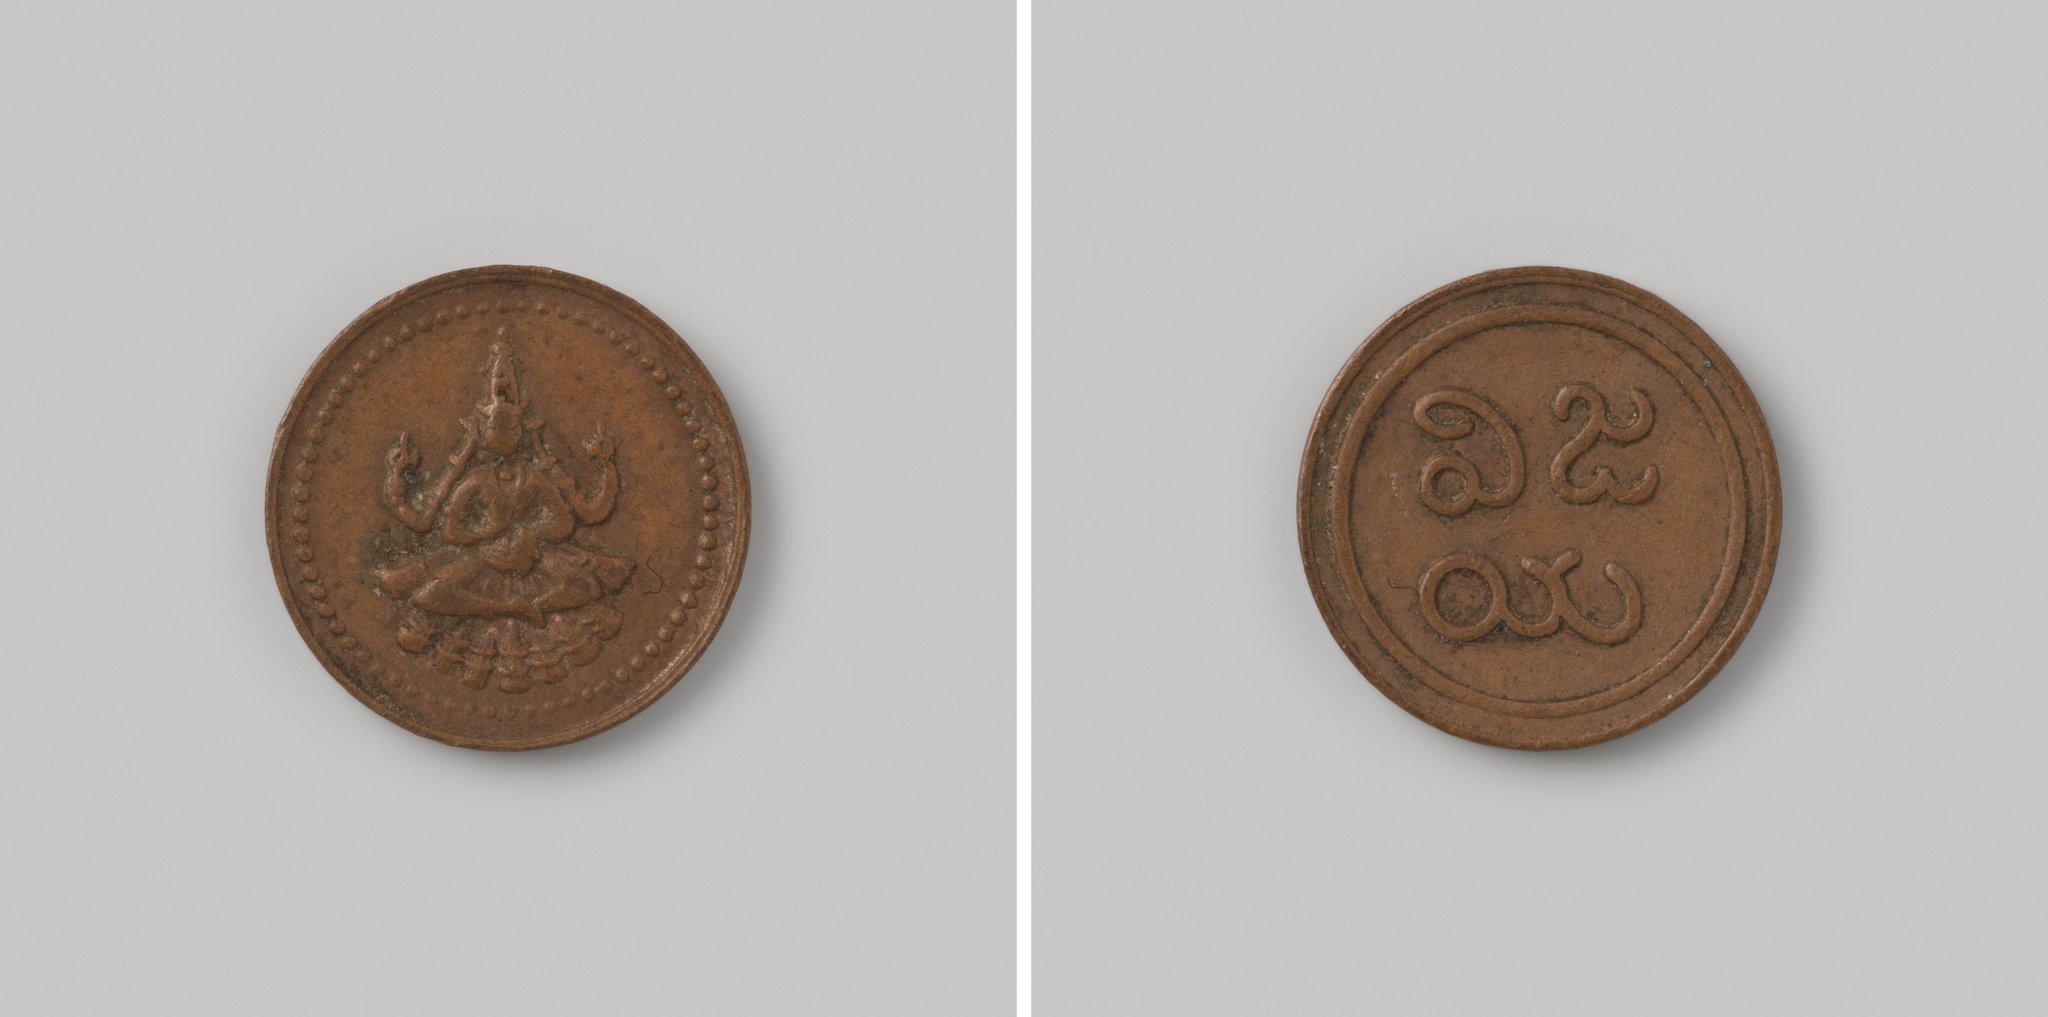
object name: coin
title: Cash uit Puducottah in India van Vijaya Raghunata Tondaman I, 1730-1767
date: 1730-1767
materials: copper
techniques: striking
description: Koperen munt. Voorzijde: gezeten Brahadamba van voren. Keerzijde: in Telingisch schrift in twee regels naam van de vorst. Gladde rand.